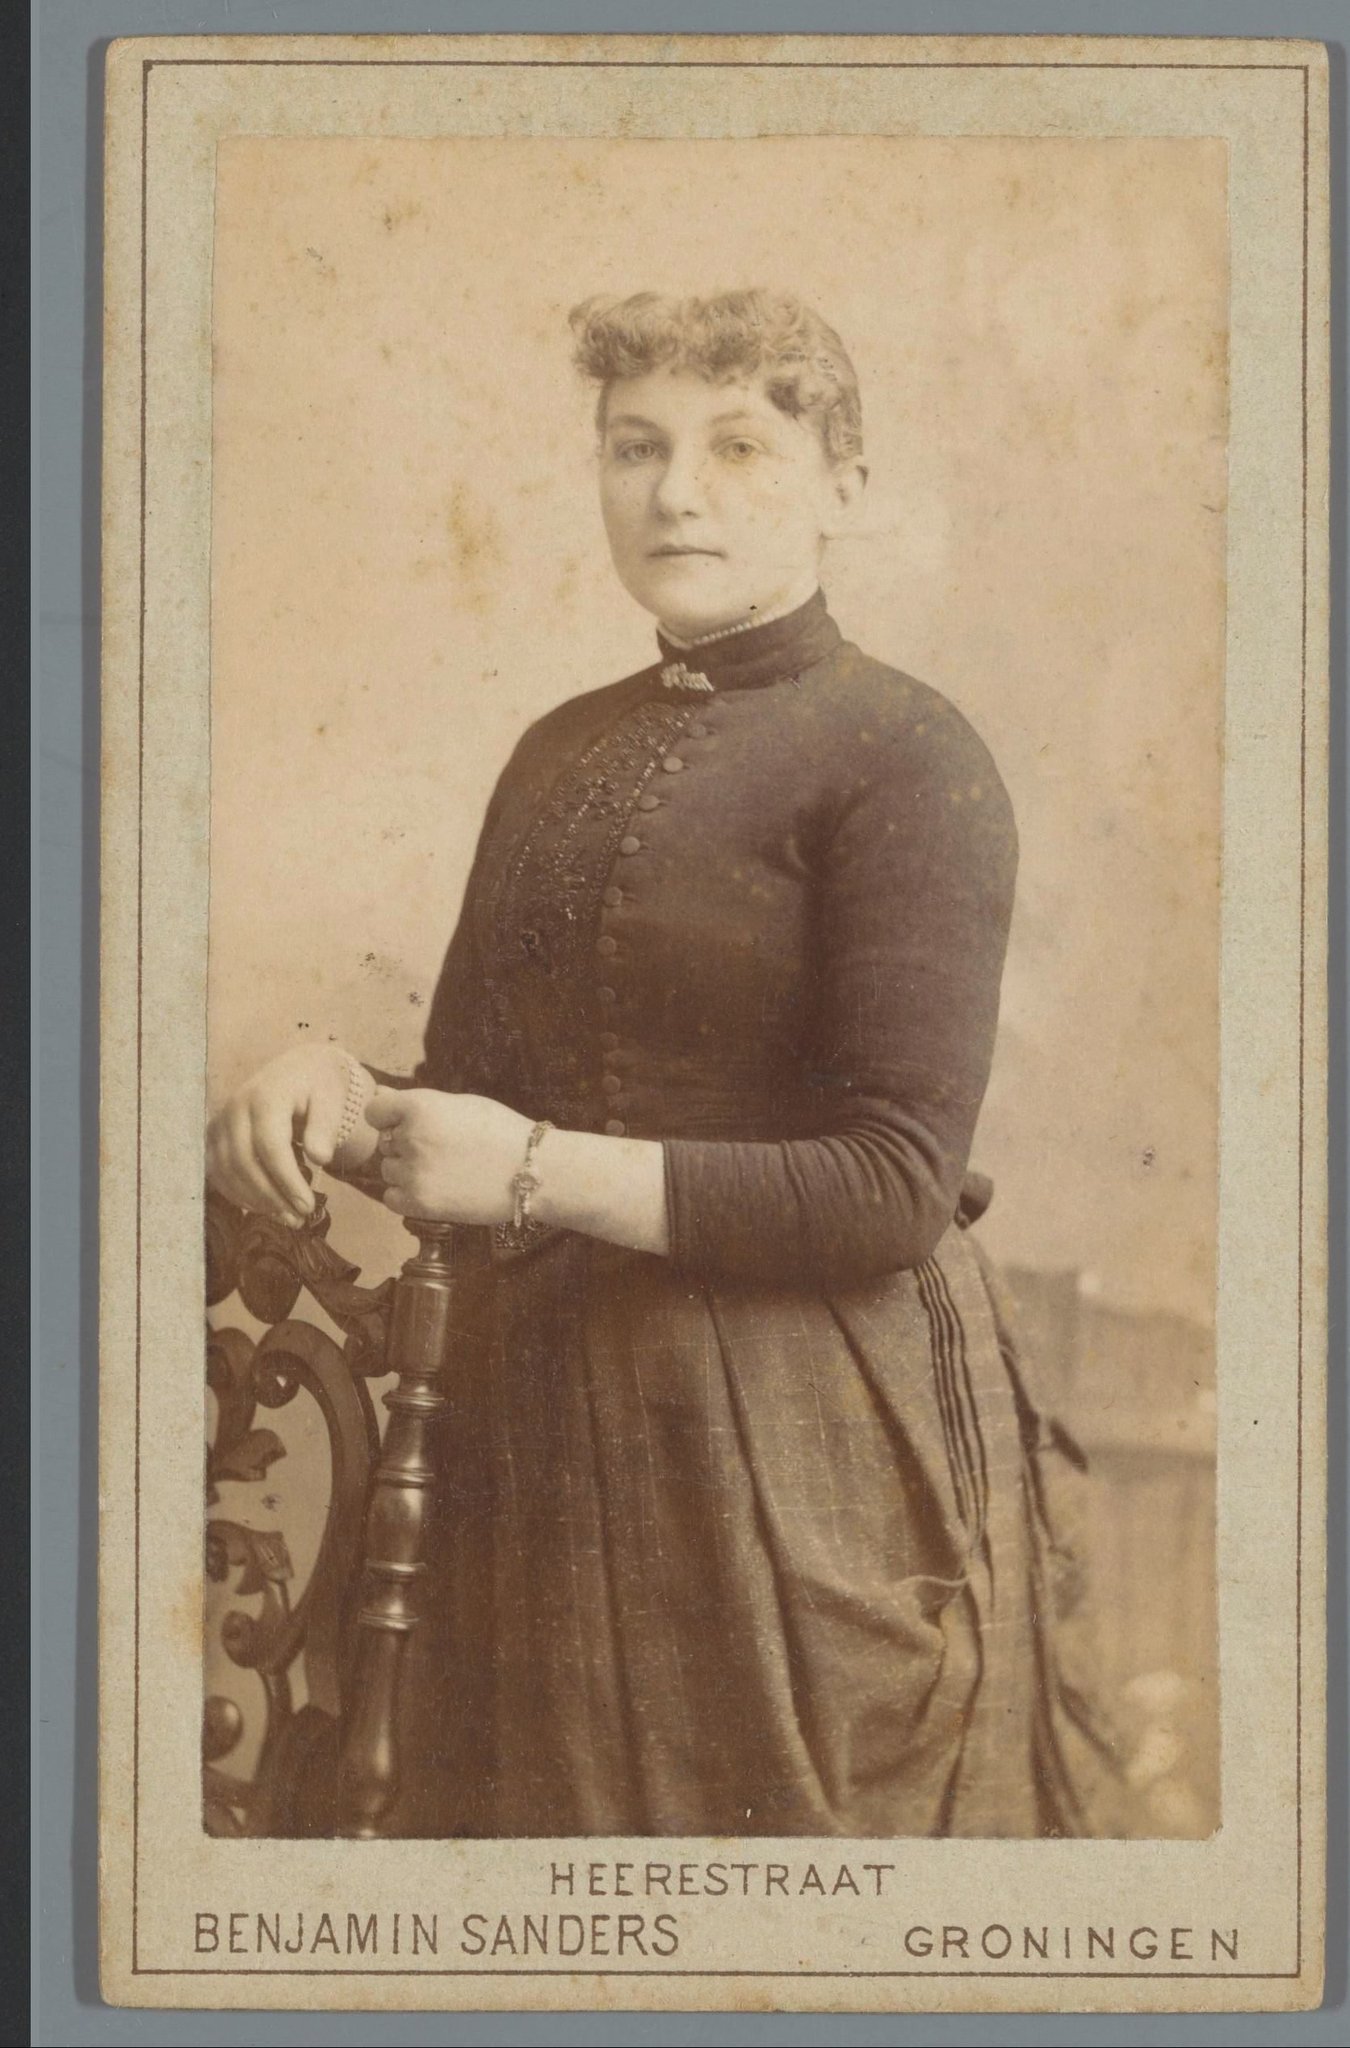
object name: photograph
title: Portret van een onbekende vrouw, aangeduid als Jetje Deelman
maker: benjamin sanders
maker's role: fotograaf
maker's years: 1841-1889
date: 1880-1889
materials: cardboard, paper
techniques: albumen print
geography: groningen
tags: historical persons - bb - woman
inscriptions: inscription: ‘Jetje Deelman’, inscription: ‘Specialiteit in Kinderopnamen/ PHotographische Ateliers/ van/ Benj. Sanders./ Groningen, Heerestraat/ Assen, Groningerdwasstraat./ Alle Photographien worden tot levensgroot nagemaakt.’